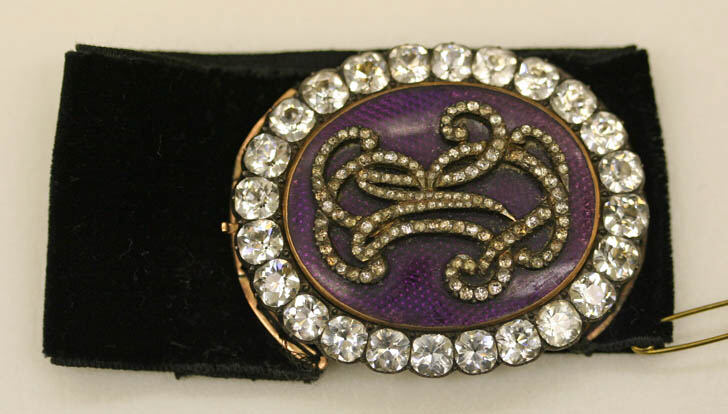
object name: bracelet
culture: french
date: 1834-1866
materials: glass, silver